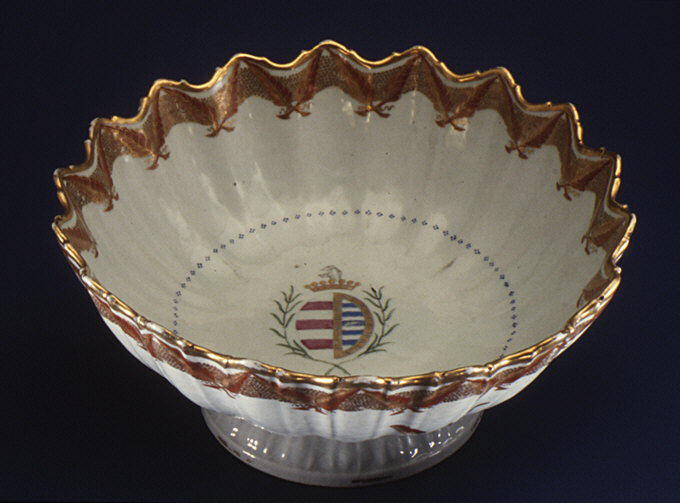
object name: bowl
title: Bowl (part of a service)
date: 1810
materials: hard paste porcelain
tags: coat of arms